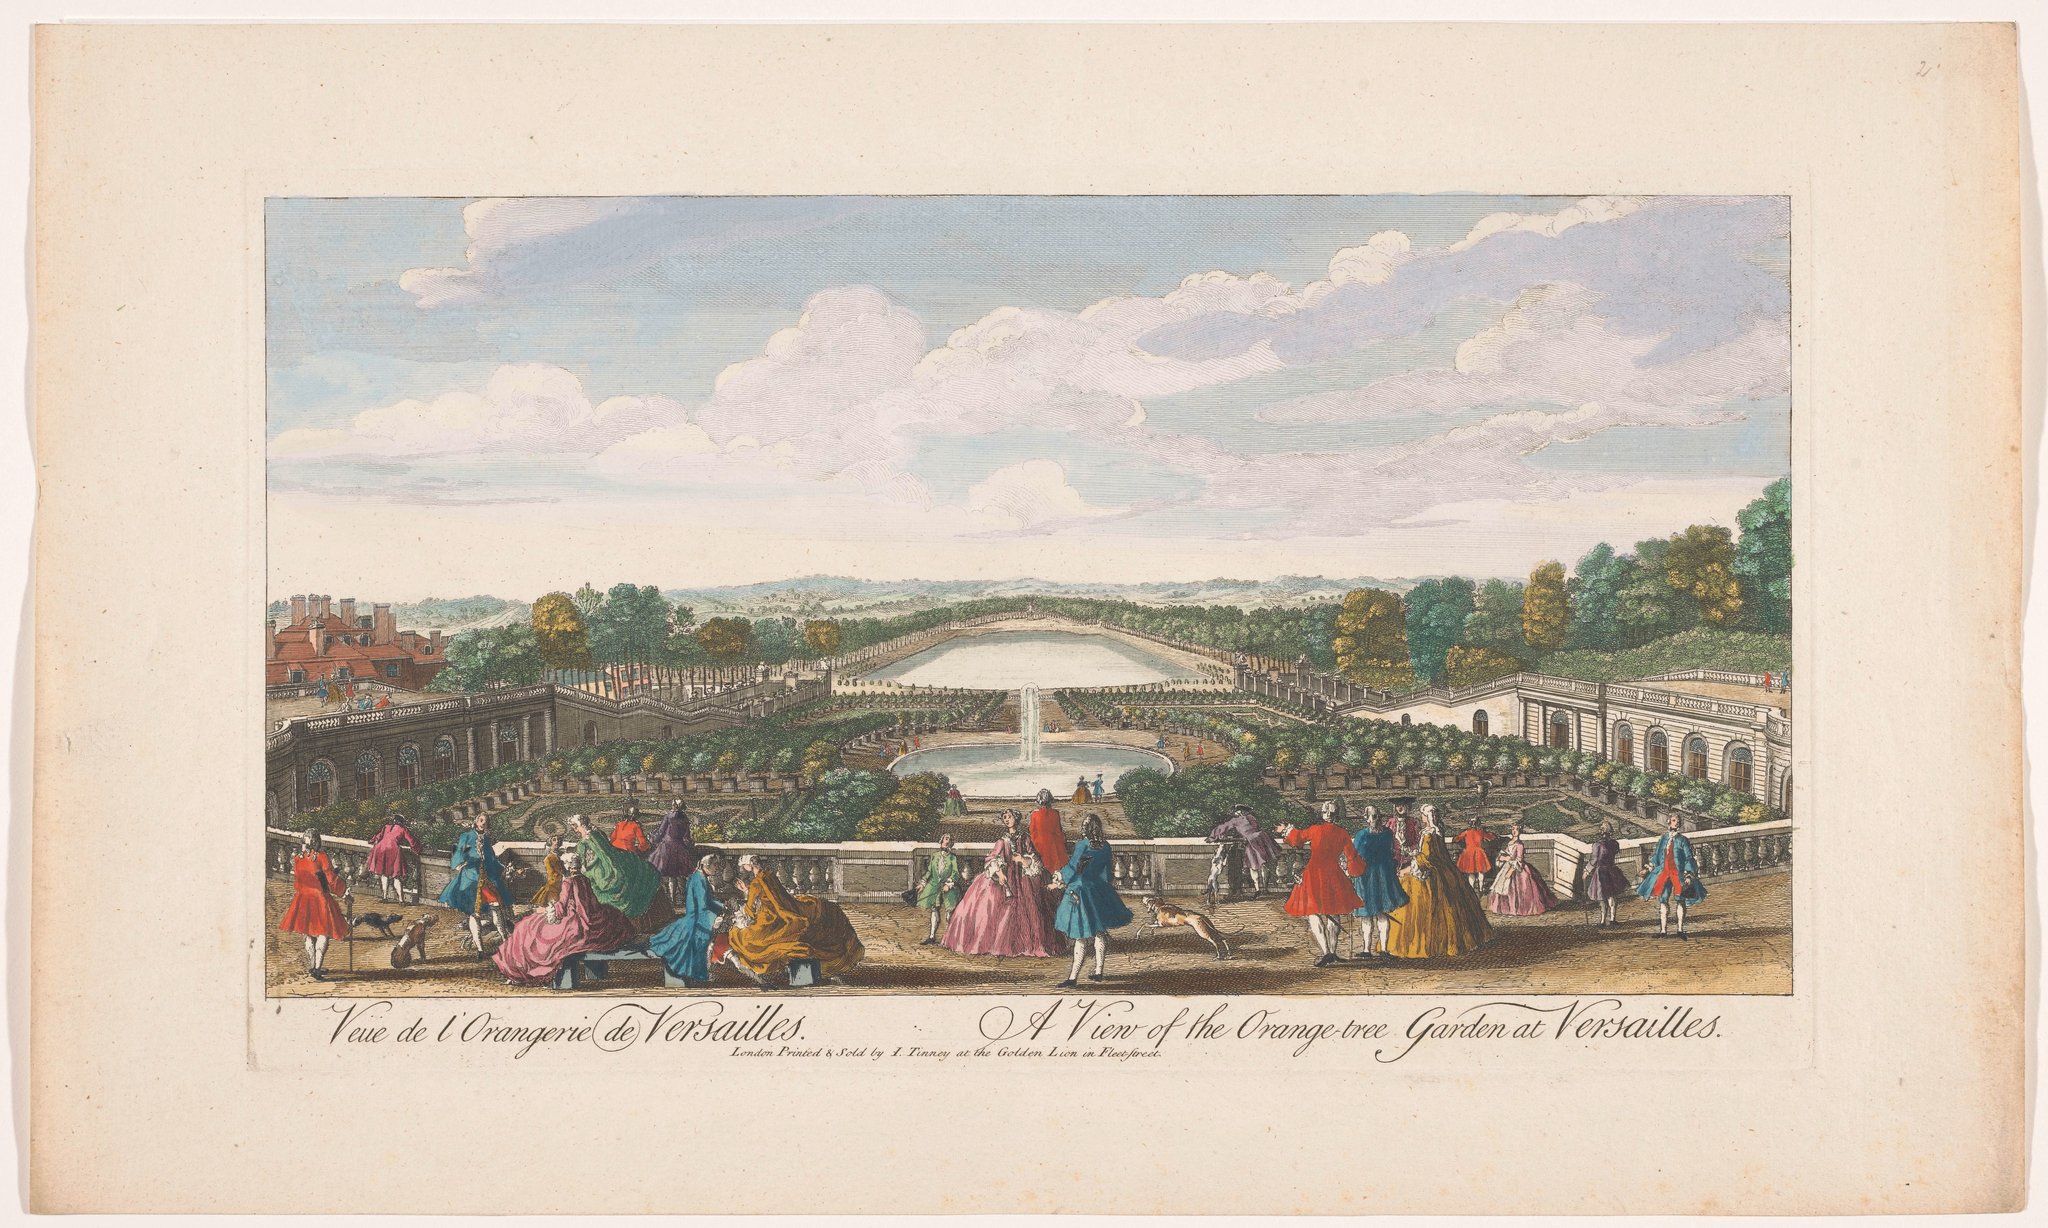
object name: print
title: A view of the orange-tree garden at Versailles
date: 1700-1761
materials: paper, watercolor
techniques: brush, etching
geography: england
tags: trees: orange-tree, garden, garden fountain, ornamental plants, greenhouse, orangery